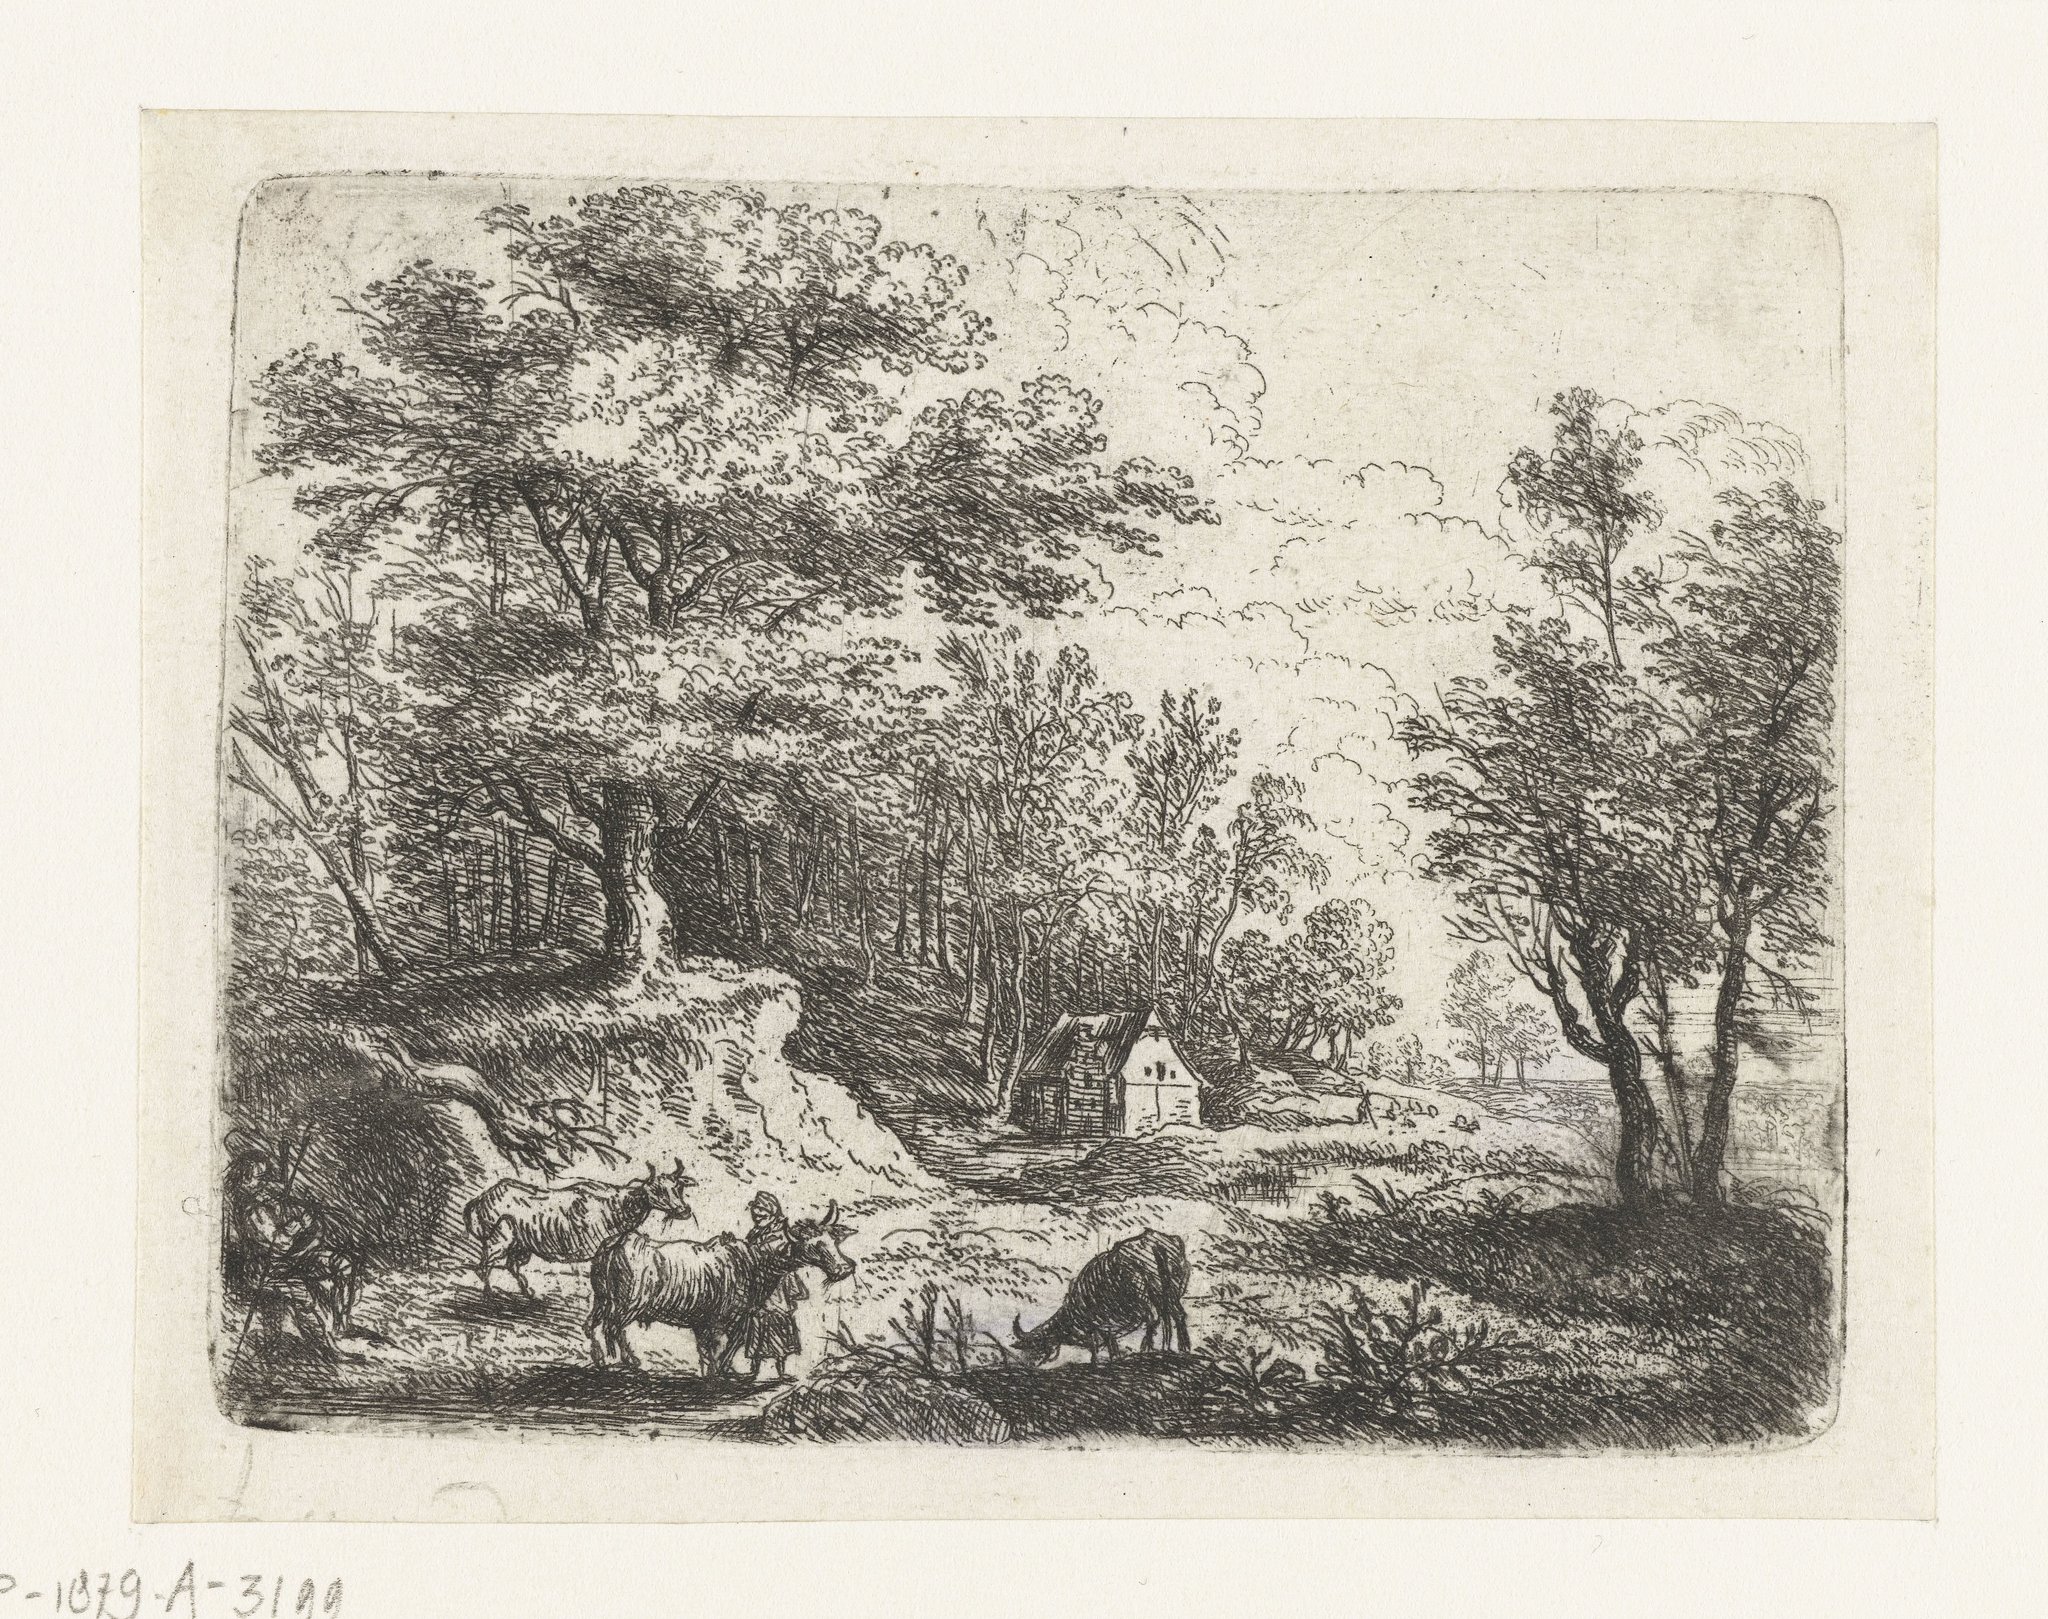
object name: print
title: Kleine landschappen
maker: lucas van uden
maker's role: draughtsman, print maker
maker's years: 1595-1673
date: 1605-1673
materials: paper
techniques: engraving, etching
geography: low countries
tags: cow, human races; peoples; nationalities (+ women), farm or solitary house in landscape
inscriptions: collector's mark: Lugt 2228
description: Uit een serie van twaalf. Landschap met drie koeien en een vrouw, geheel links een zittende man met een stok. Op de achtergrond een boerderij bij een bosrand.